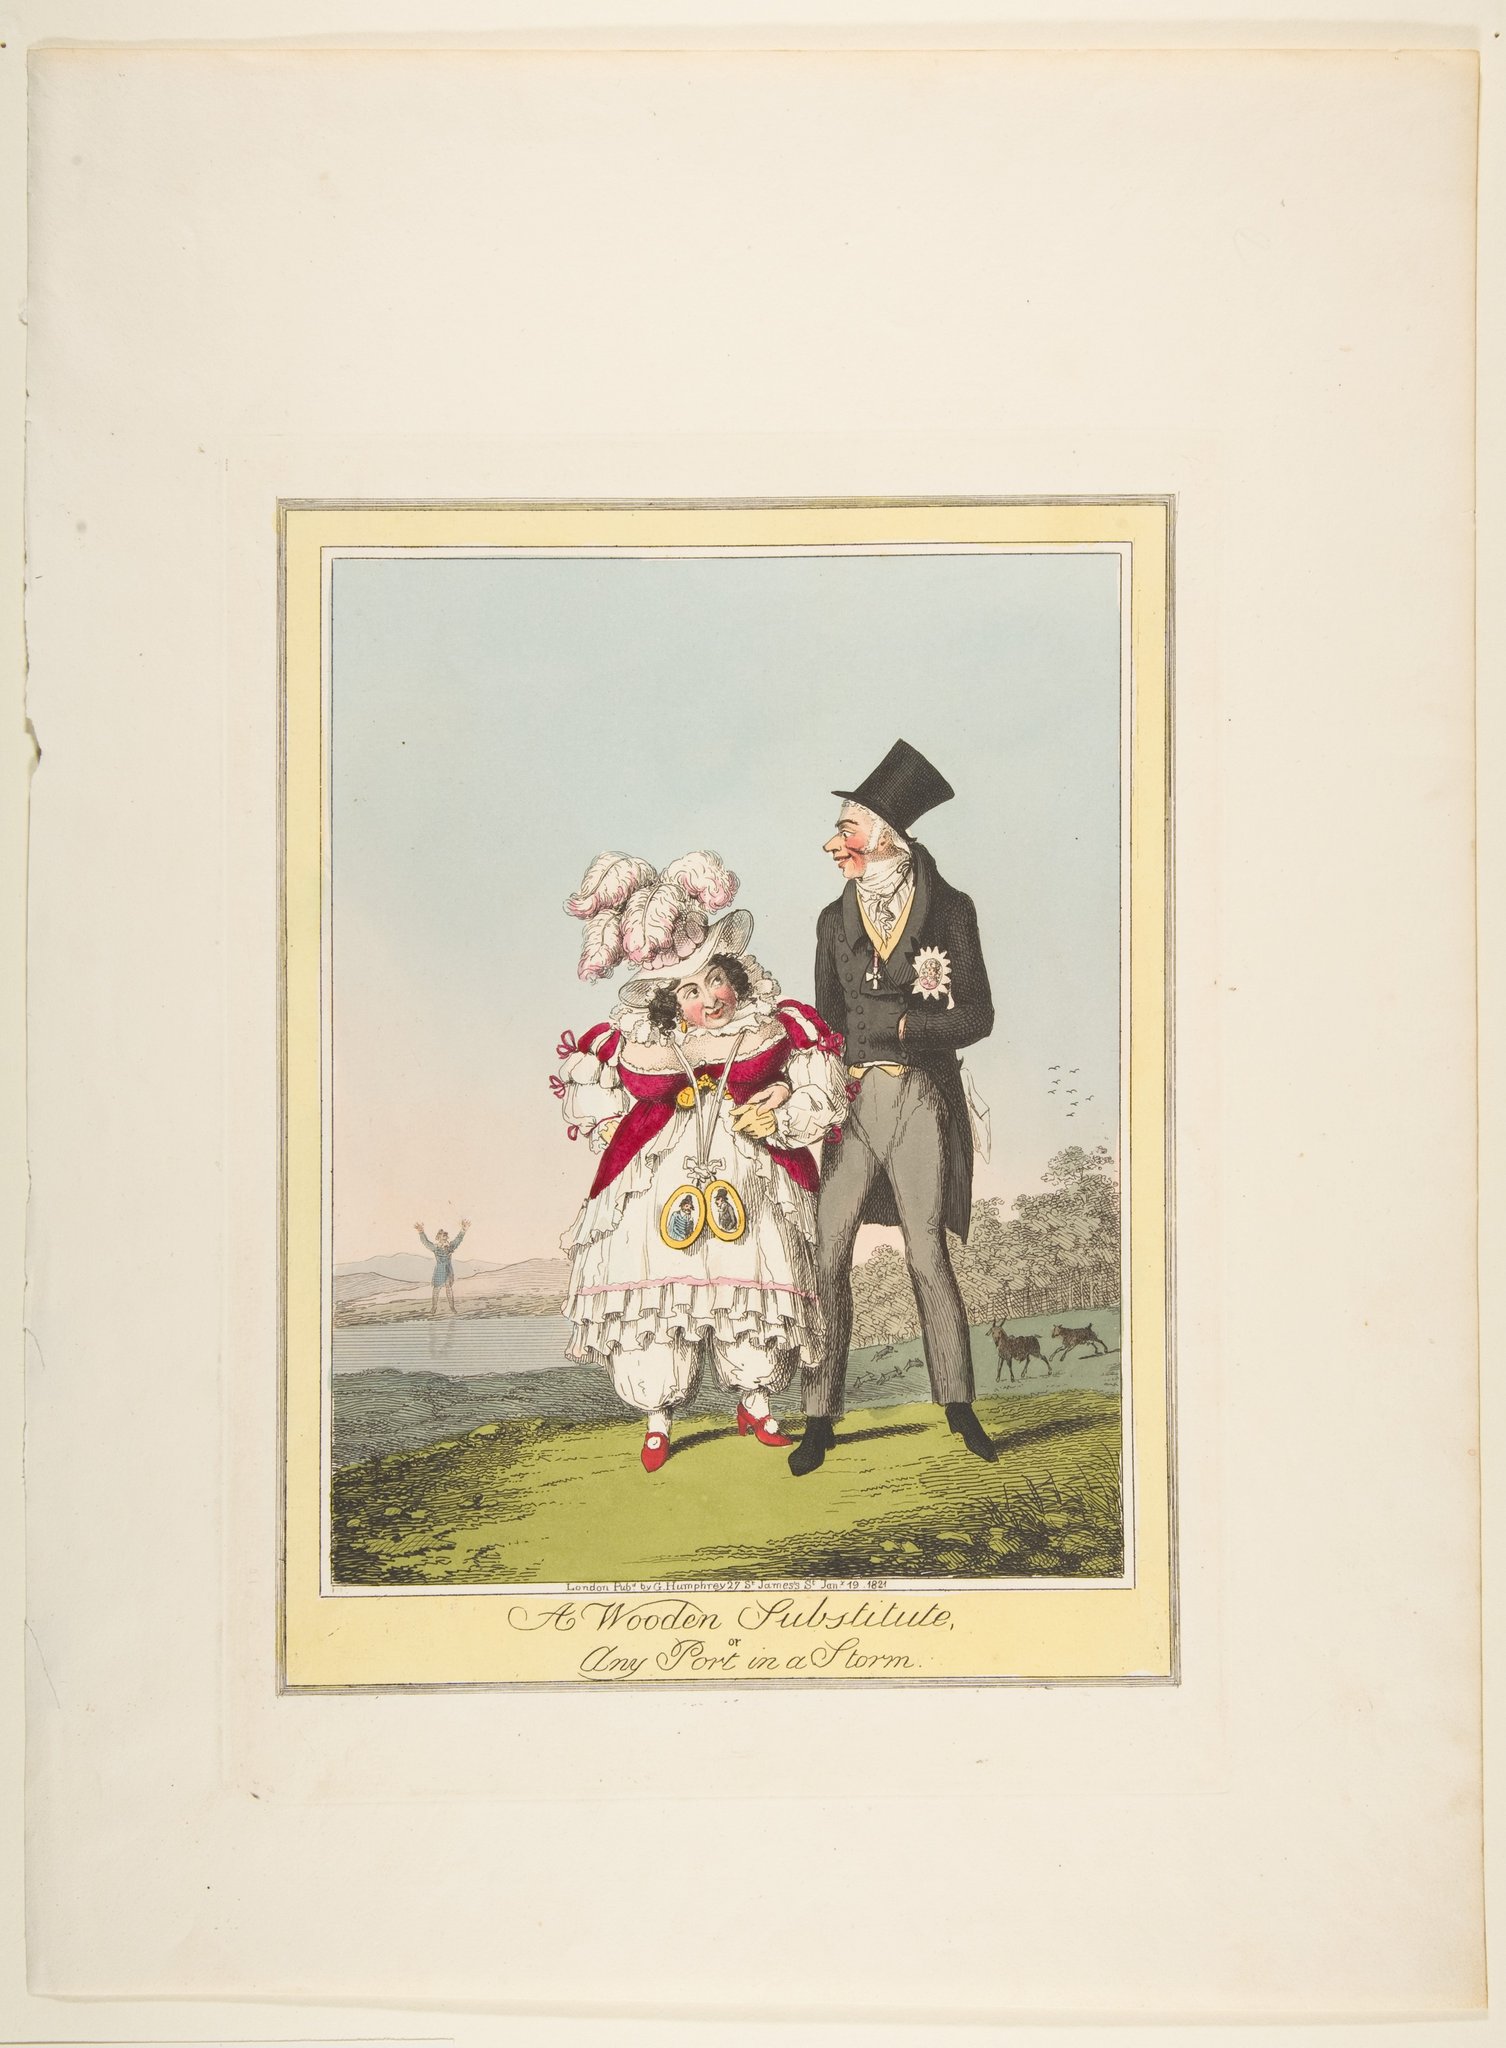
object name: print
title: A Wooden Substitute, or Any Port in a Storm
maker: theodore lane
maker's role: artist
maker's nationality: british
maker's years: 1800-1828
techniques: etching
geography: london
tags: satire,men,women,politics